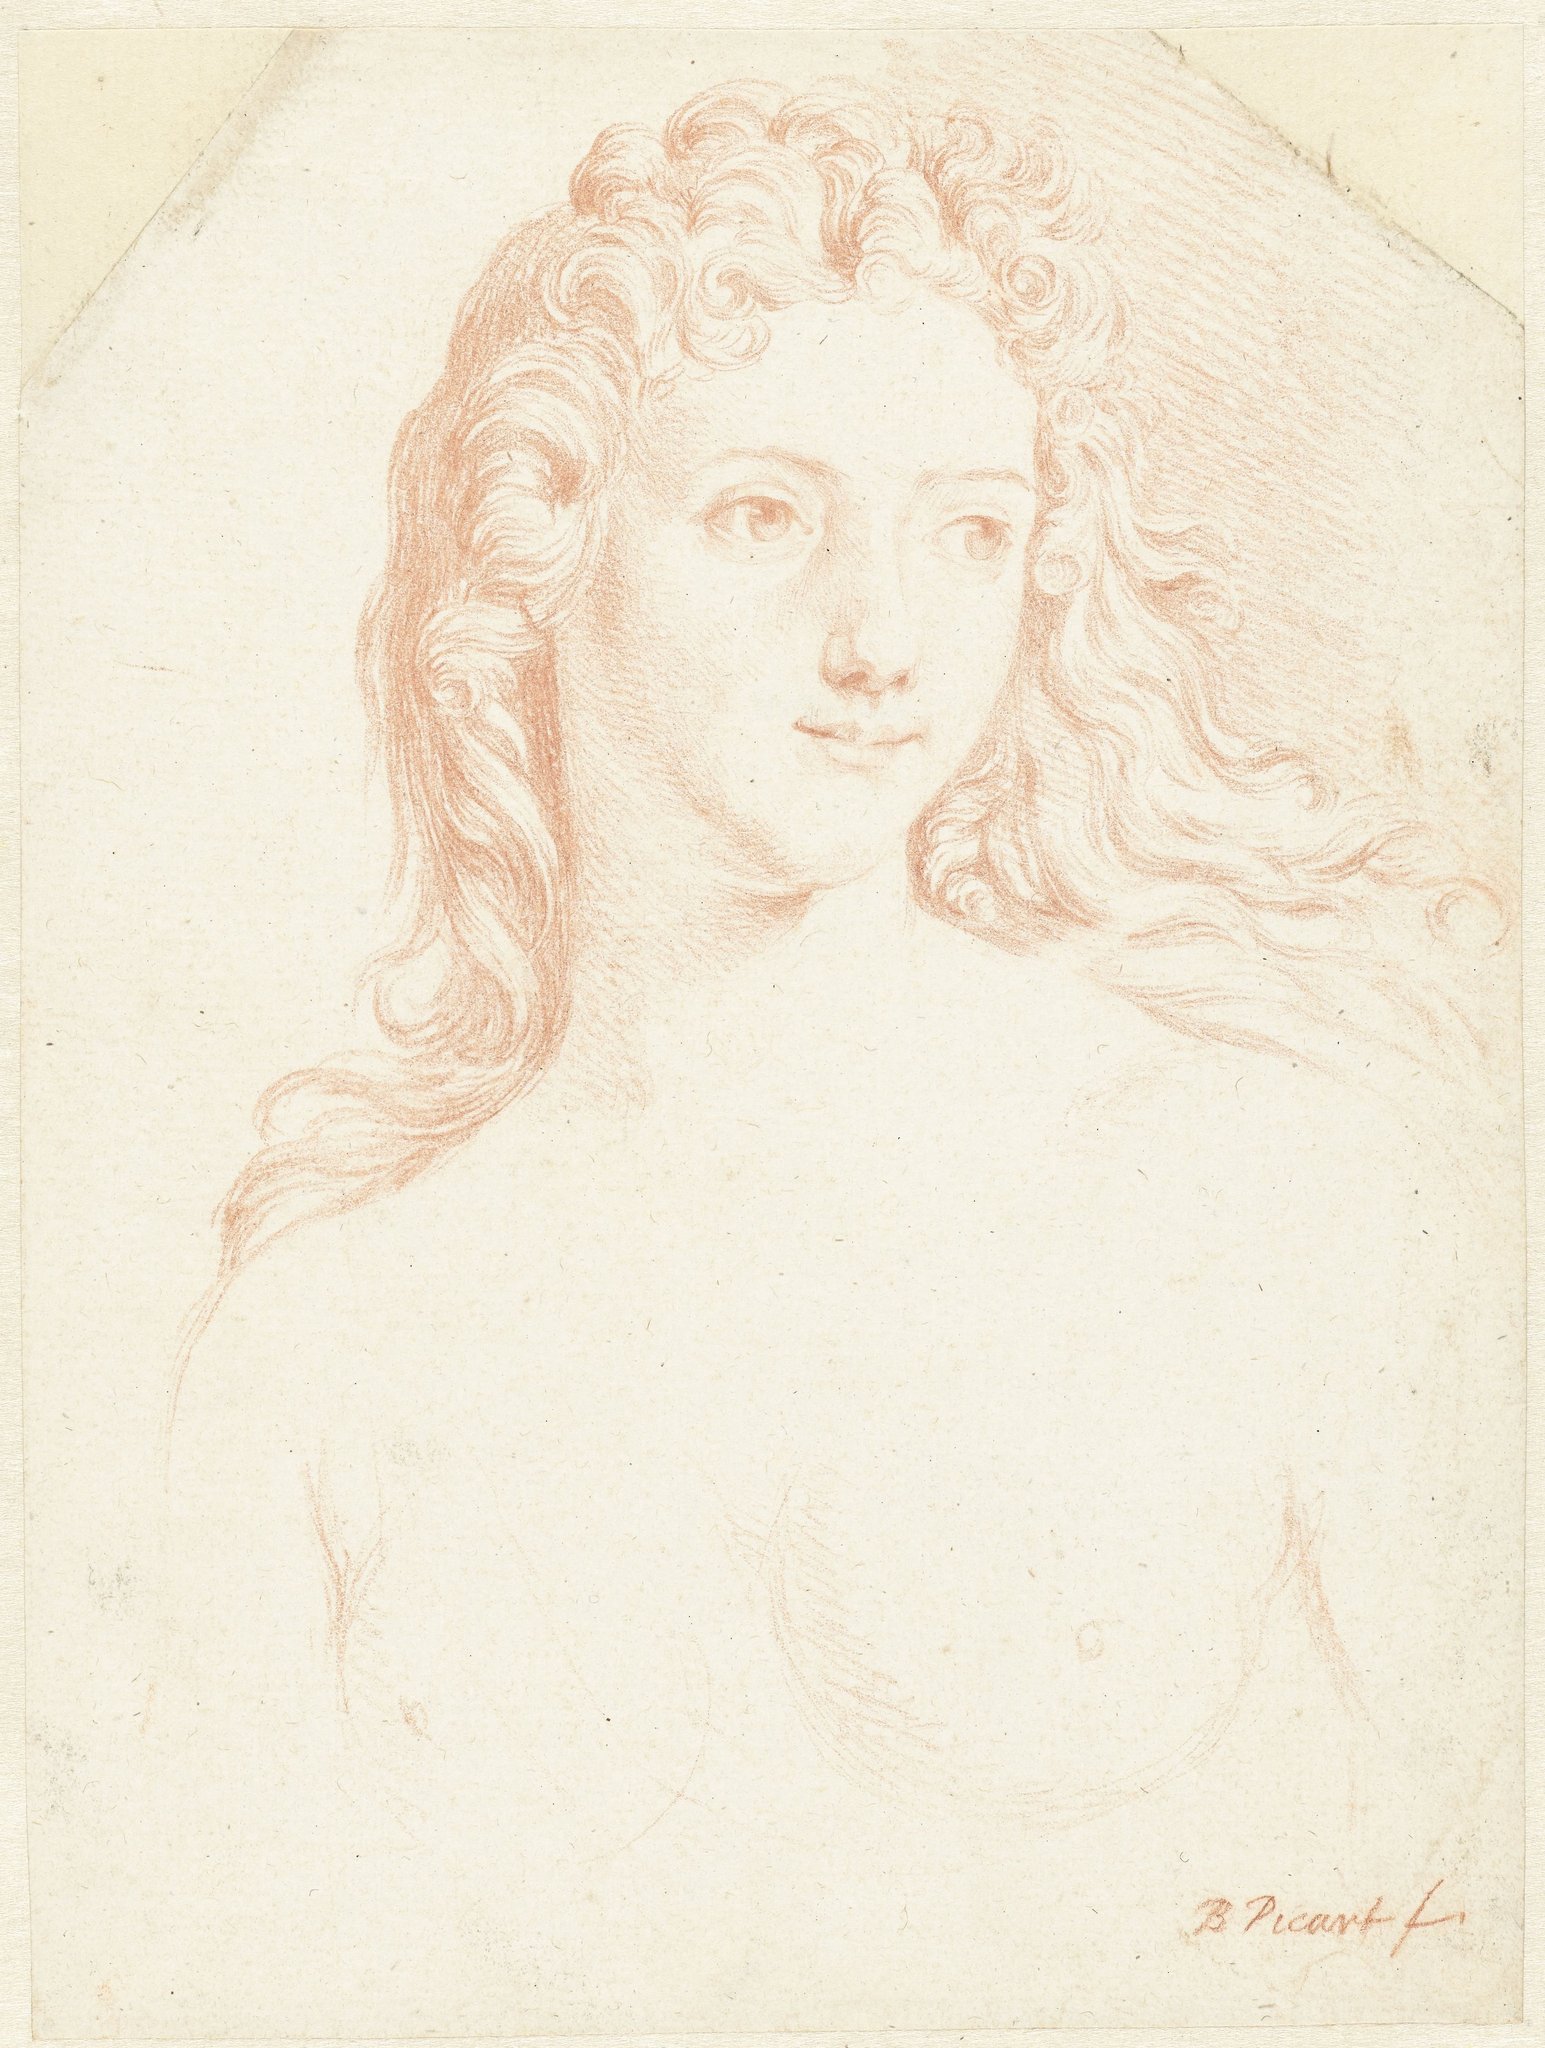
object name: drawing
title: Halffiguur van staande naakte vrouw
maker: bernard picart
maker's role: draughtsman, print maker, publisher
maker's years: 1673-1733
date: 1683-1733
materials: chalk, paper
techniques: printmaking